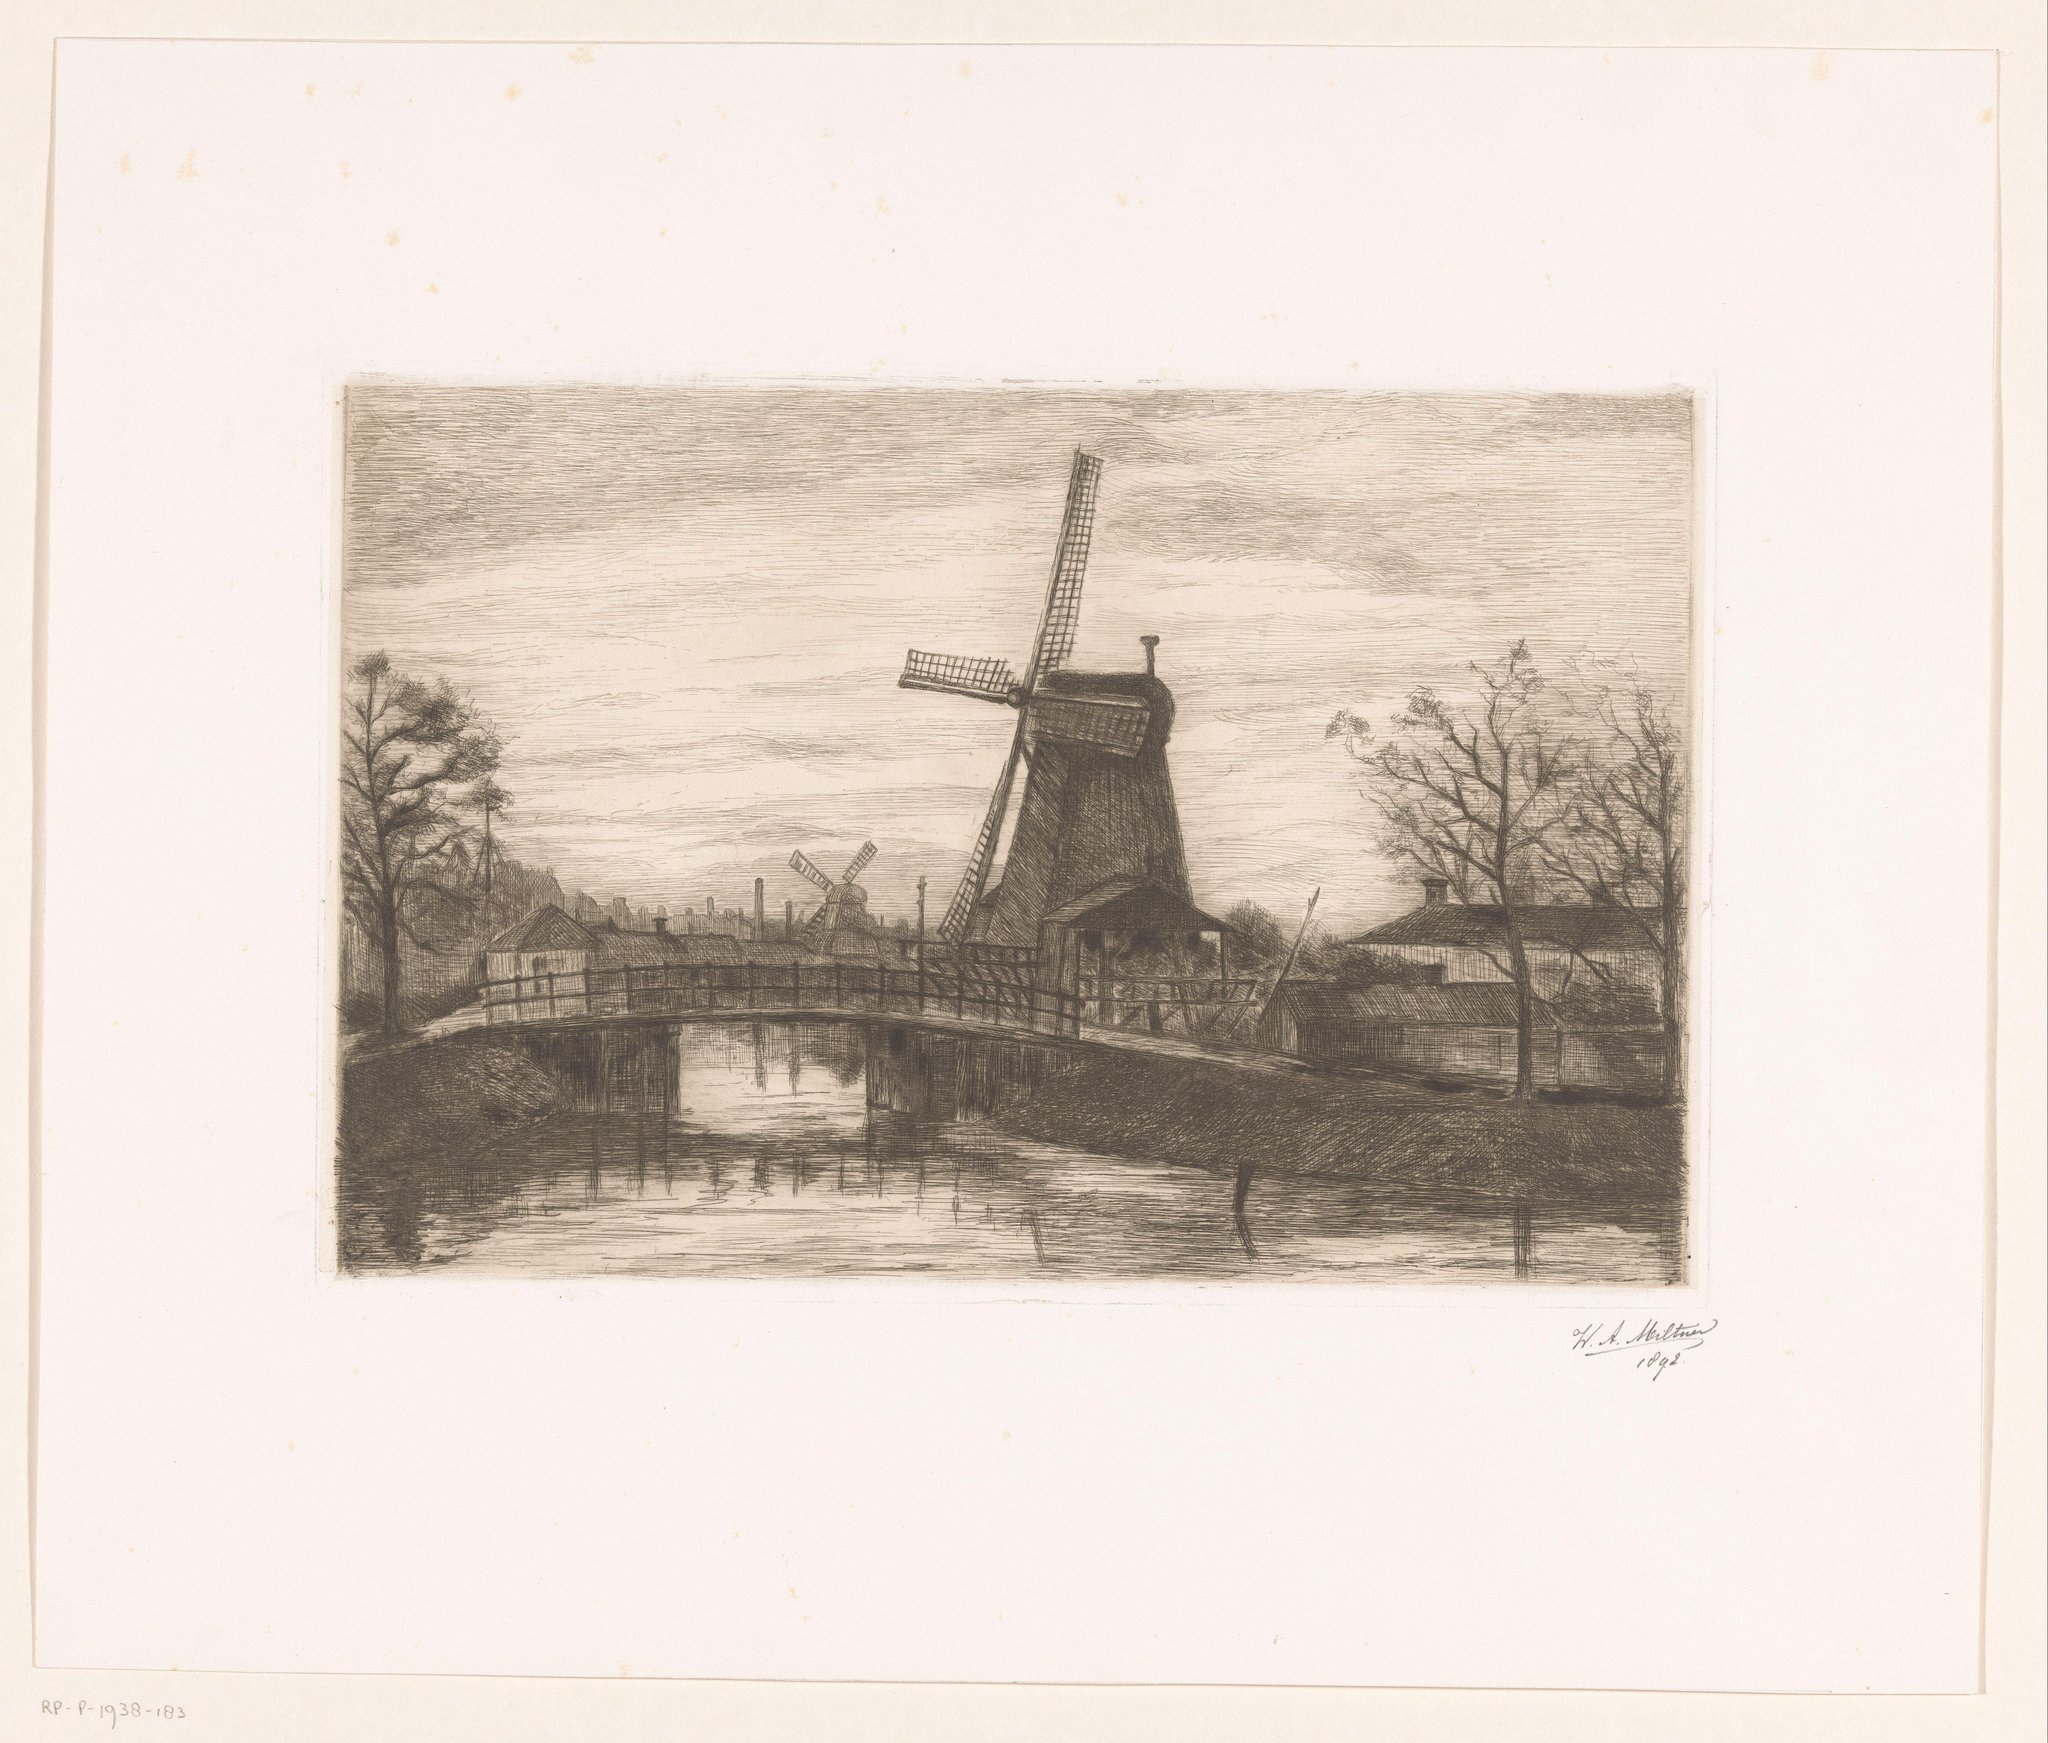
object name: print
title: Stadsgezicht met twee molens en een brug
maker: w.a. miltner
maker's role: print maker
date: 1892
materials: paper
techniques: etching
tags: city-view in general; 'veduta', windmill in landscape, bridge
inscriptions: collector's mark: Lugt 2760, collector's mark: Lugt 2228